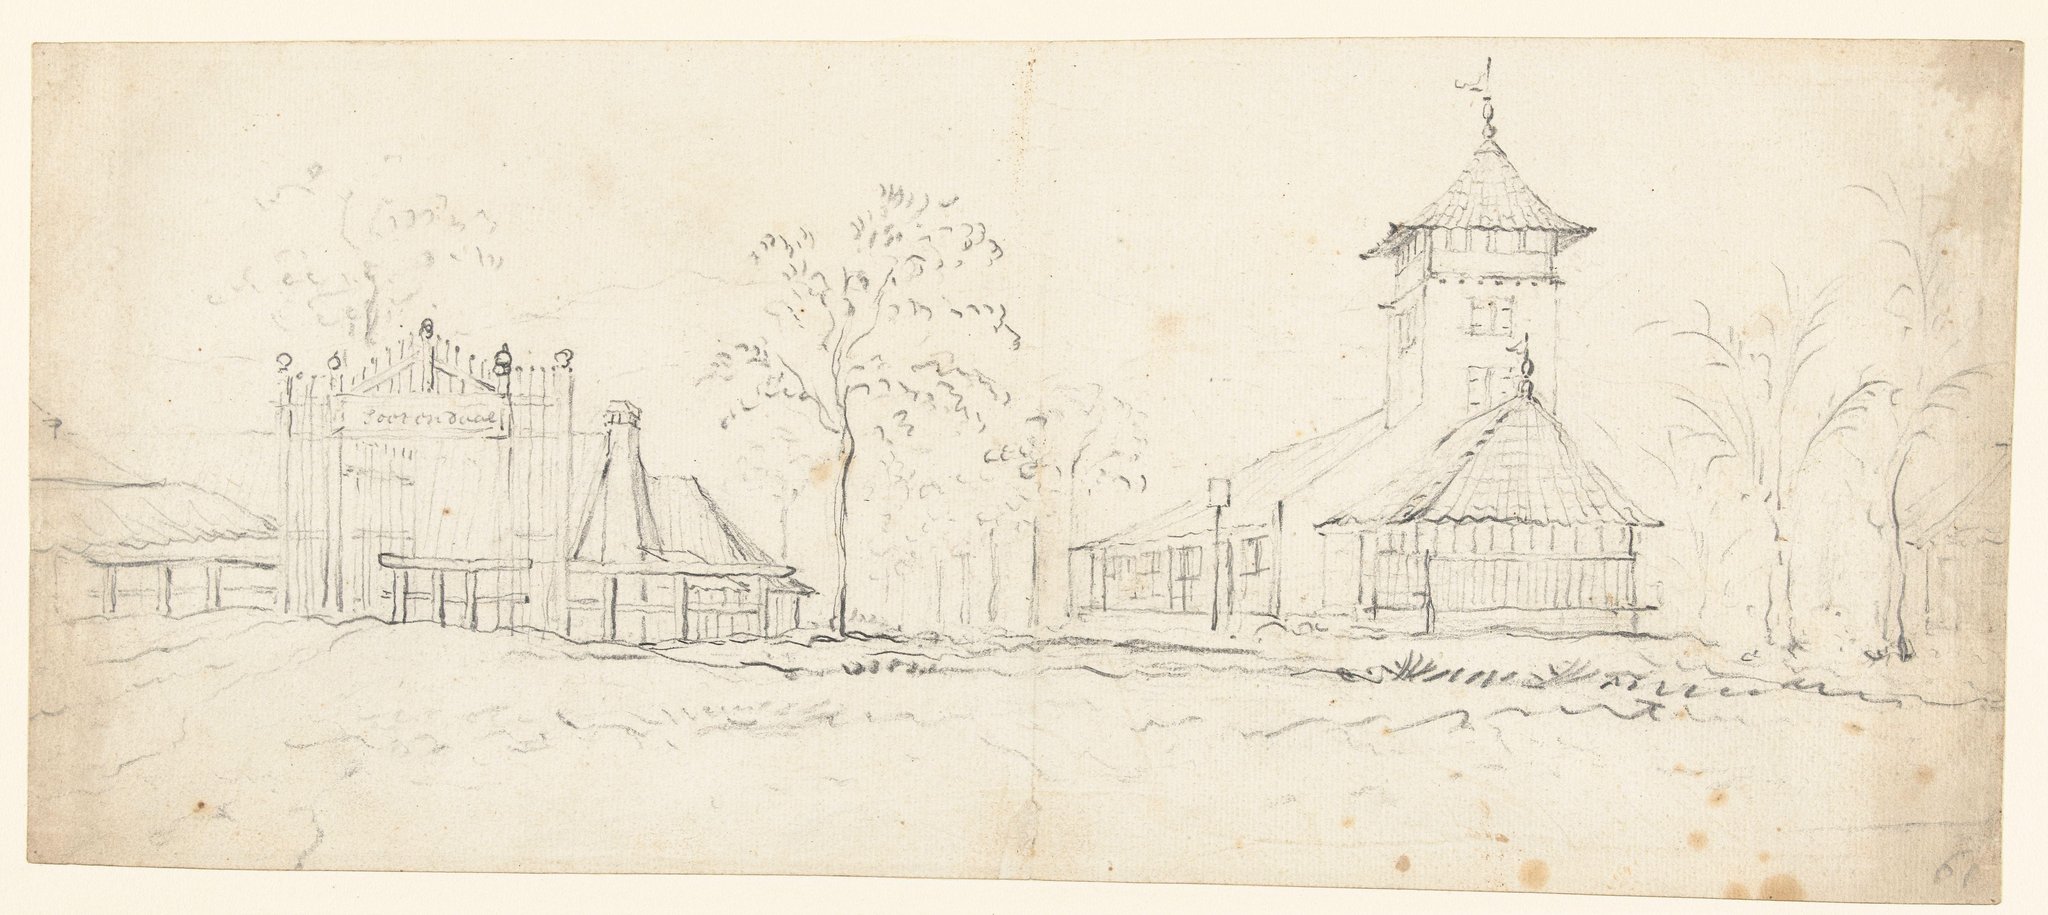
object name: drawing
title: Buitenplaats Soorendaal met een kerk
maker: Anonymous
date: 1700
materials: chalk, paper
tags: soorendaal